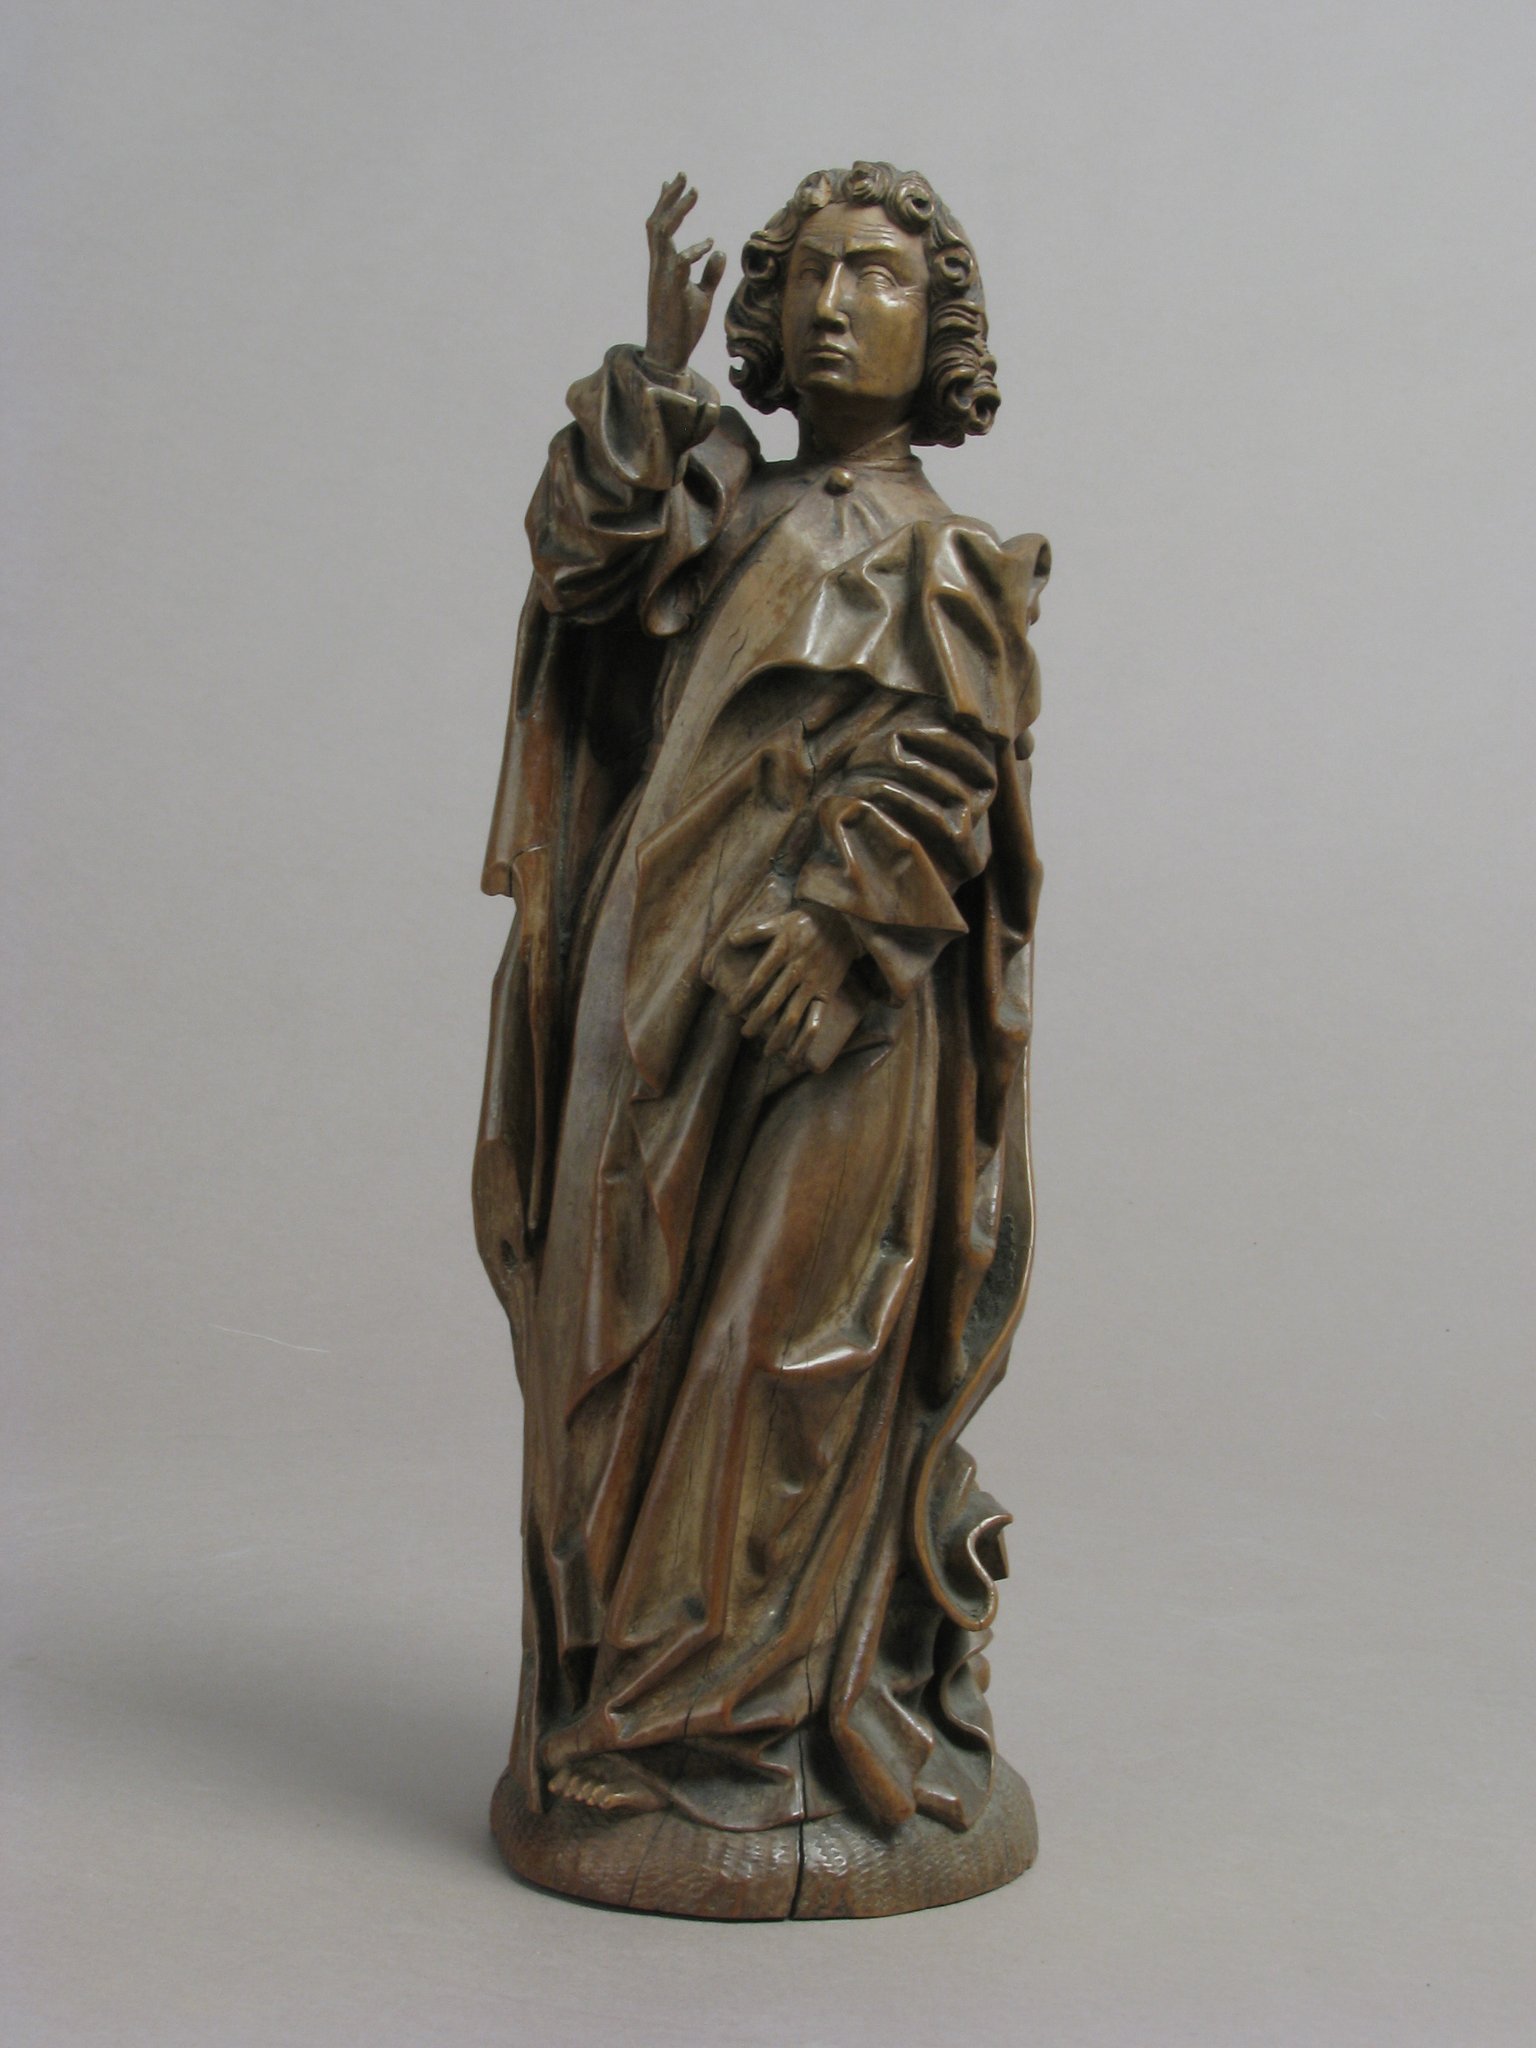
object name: statuette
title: Saint John The Evangelist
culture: german or south netherlandish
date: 1401-1500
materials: wood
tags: saint john the evangelist